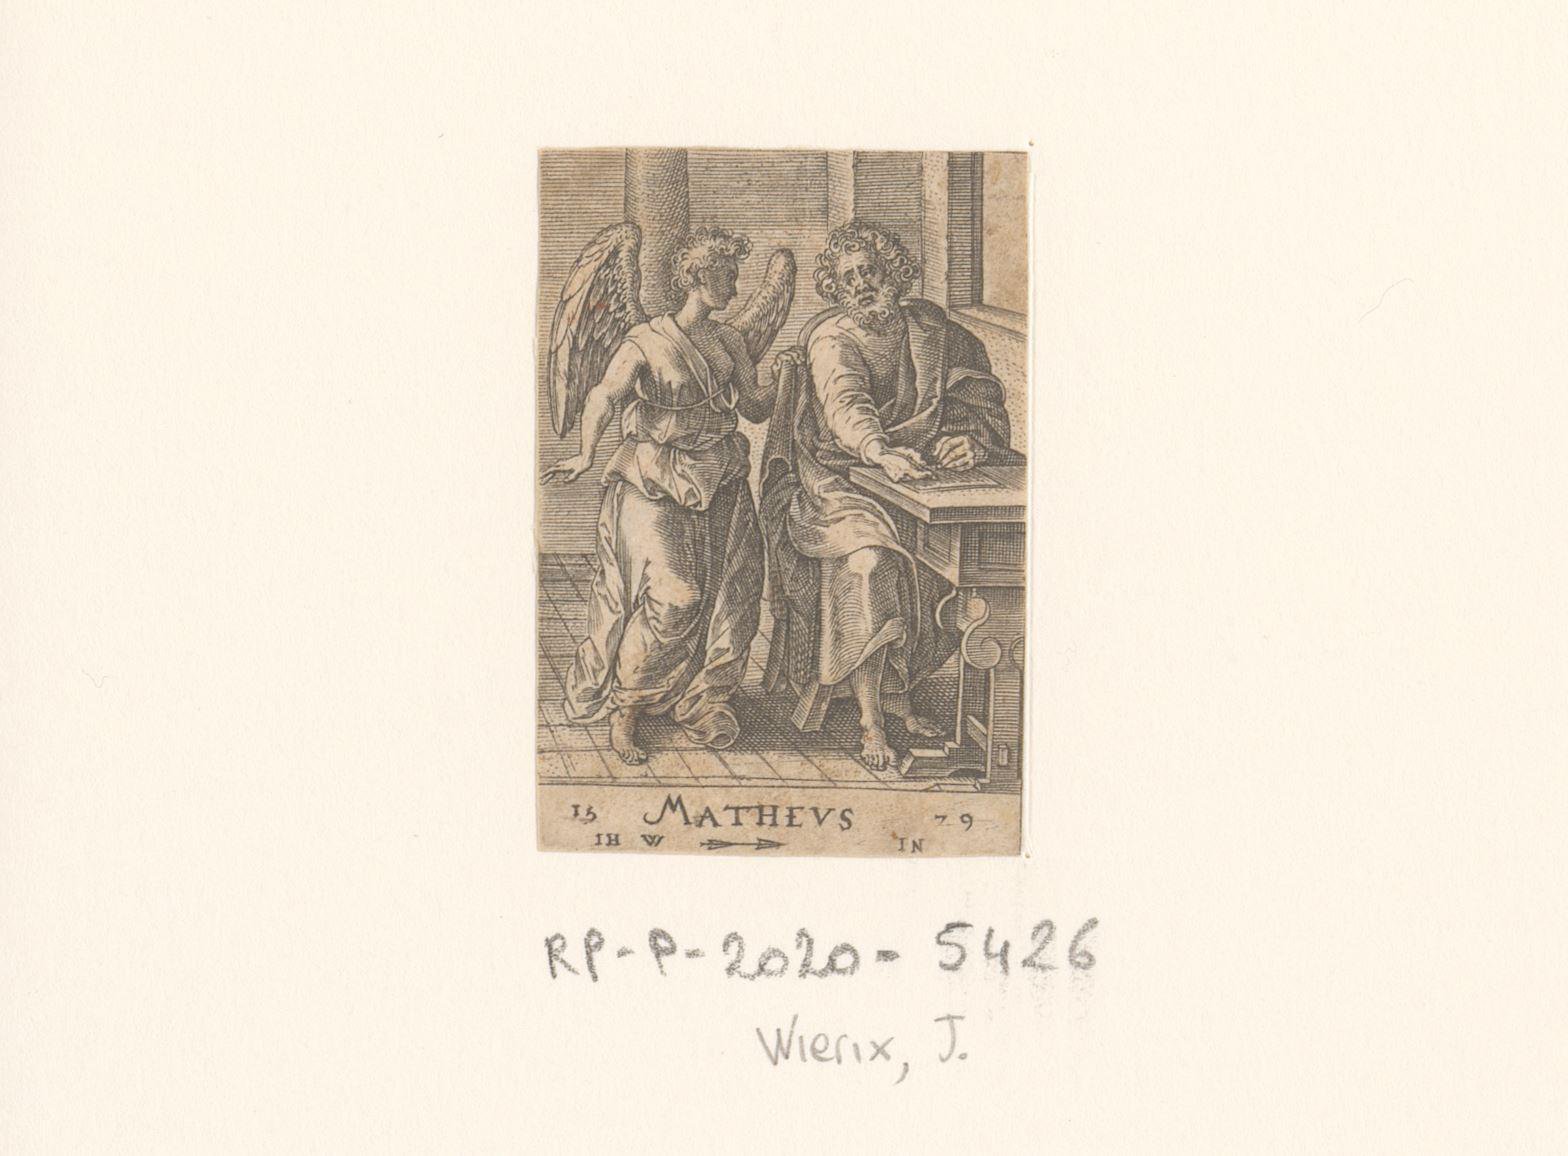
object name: print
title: Vier evangelisten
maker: johannes wierix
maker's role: draughtsman, print maker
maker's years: 1549-1618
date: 1579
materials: paper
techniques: engraving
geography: antwerp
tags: st. matthew writing the gospel, usually the angel present, dictating or assisting him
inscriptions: collector's mark: Lugt 1337, collector's mark: Lugt 2228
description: Prent met tekst in boekdruk op verso gebruikt in 'Const-Tonneel', in 1609 uitgegeven door Nicolaes de Clerck.